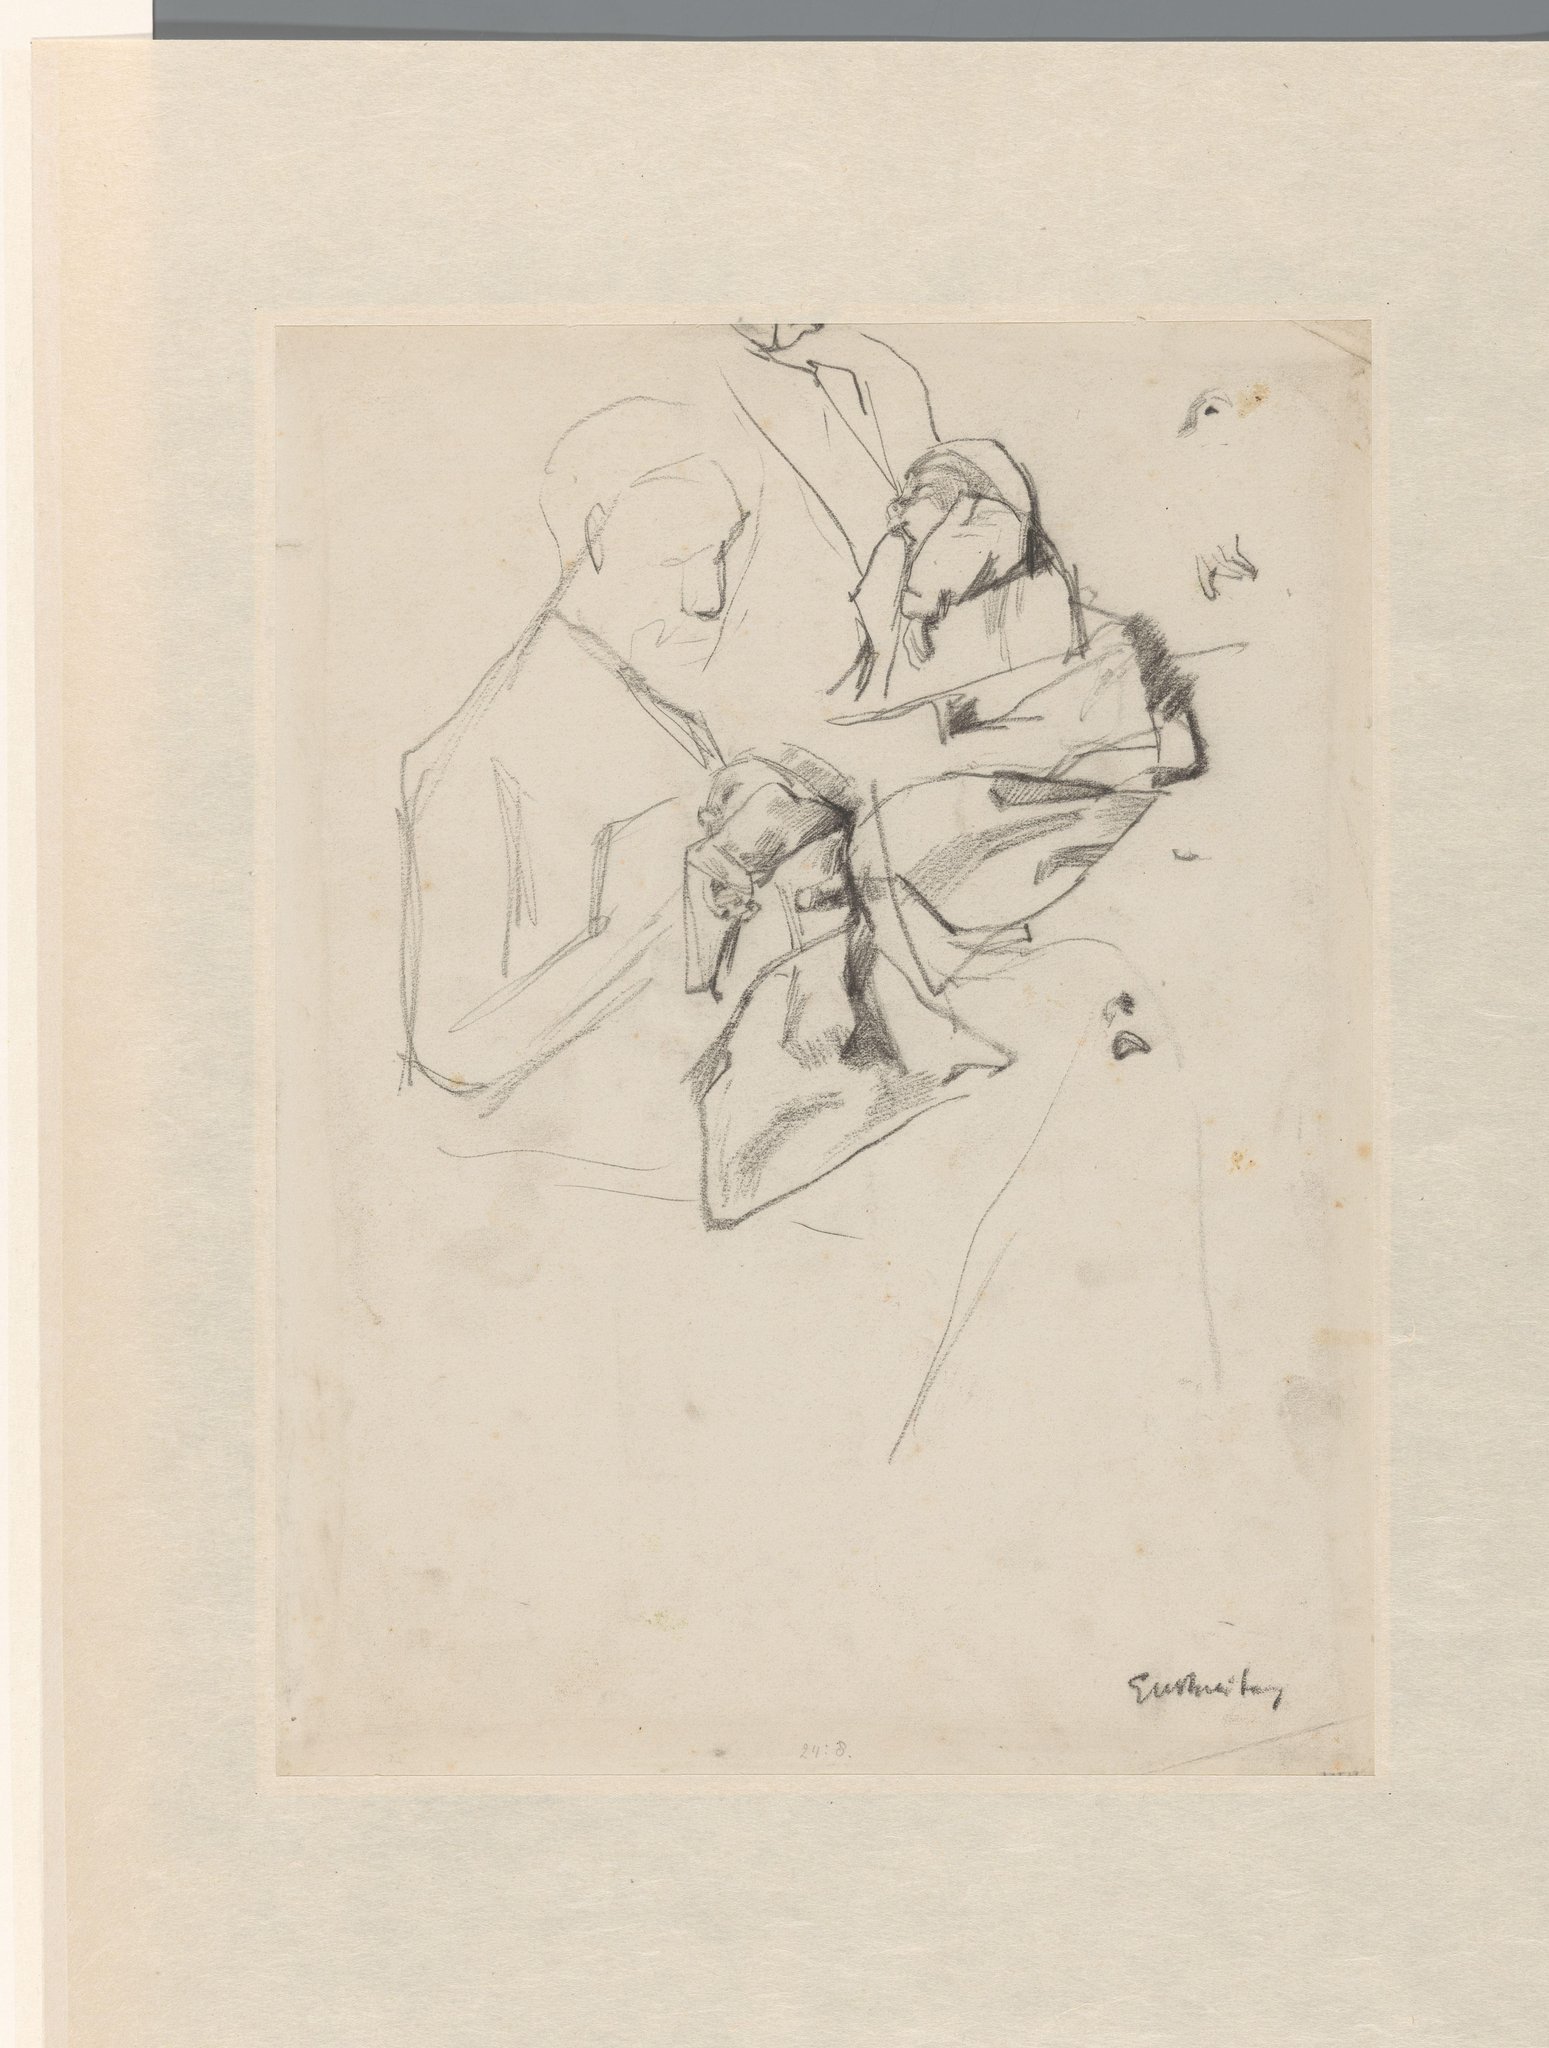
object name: drawing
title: Schets van een persoon met een kind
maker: george hendrik breitner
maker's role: draughtsman, painter, print maker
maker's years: 1857-1923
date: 1867-1923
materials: chalk, paper